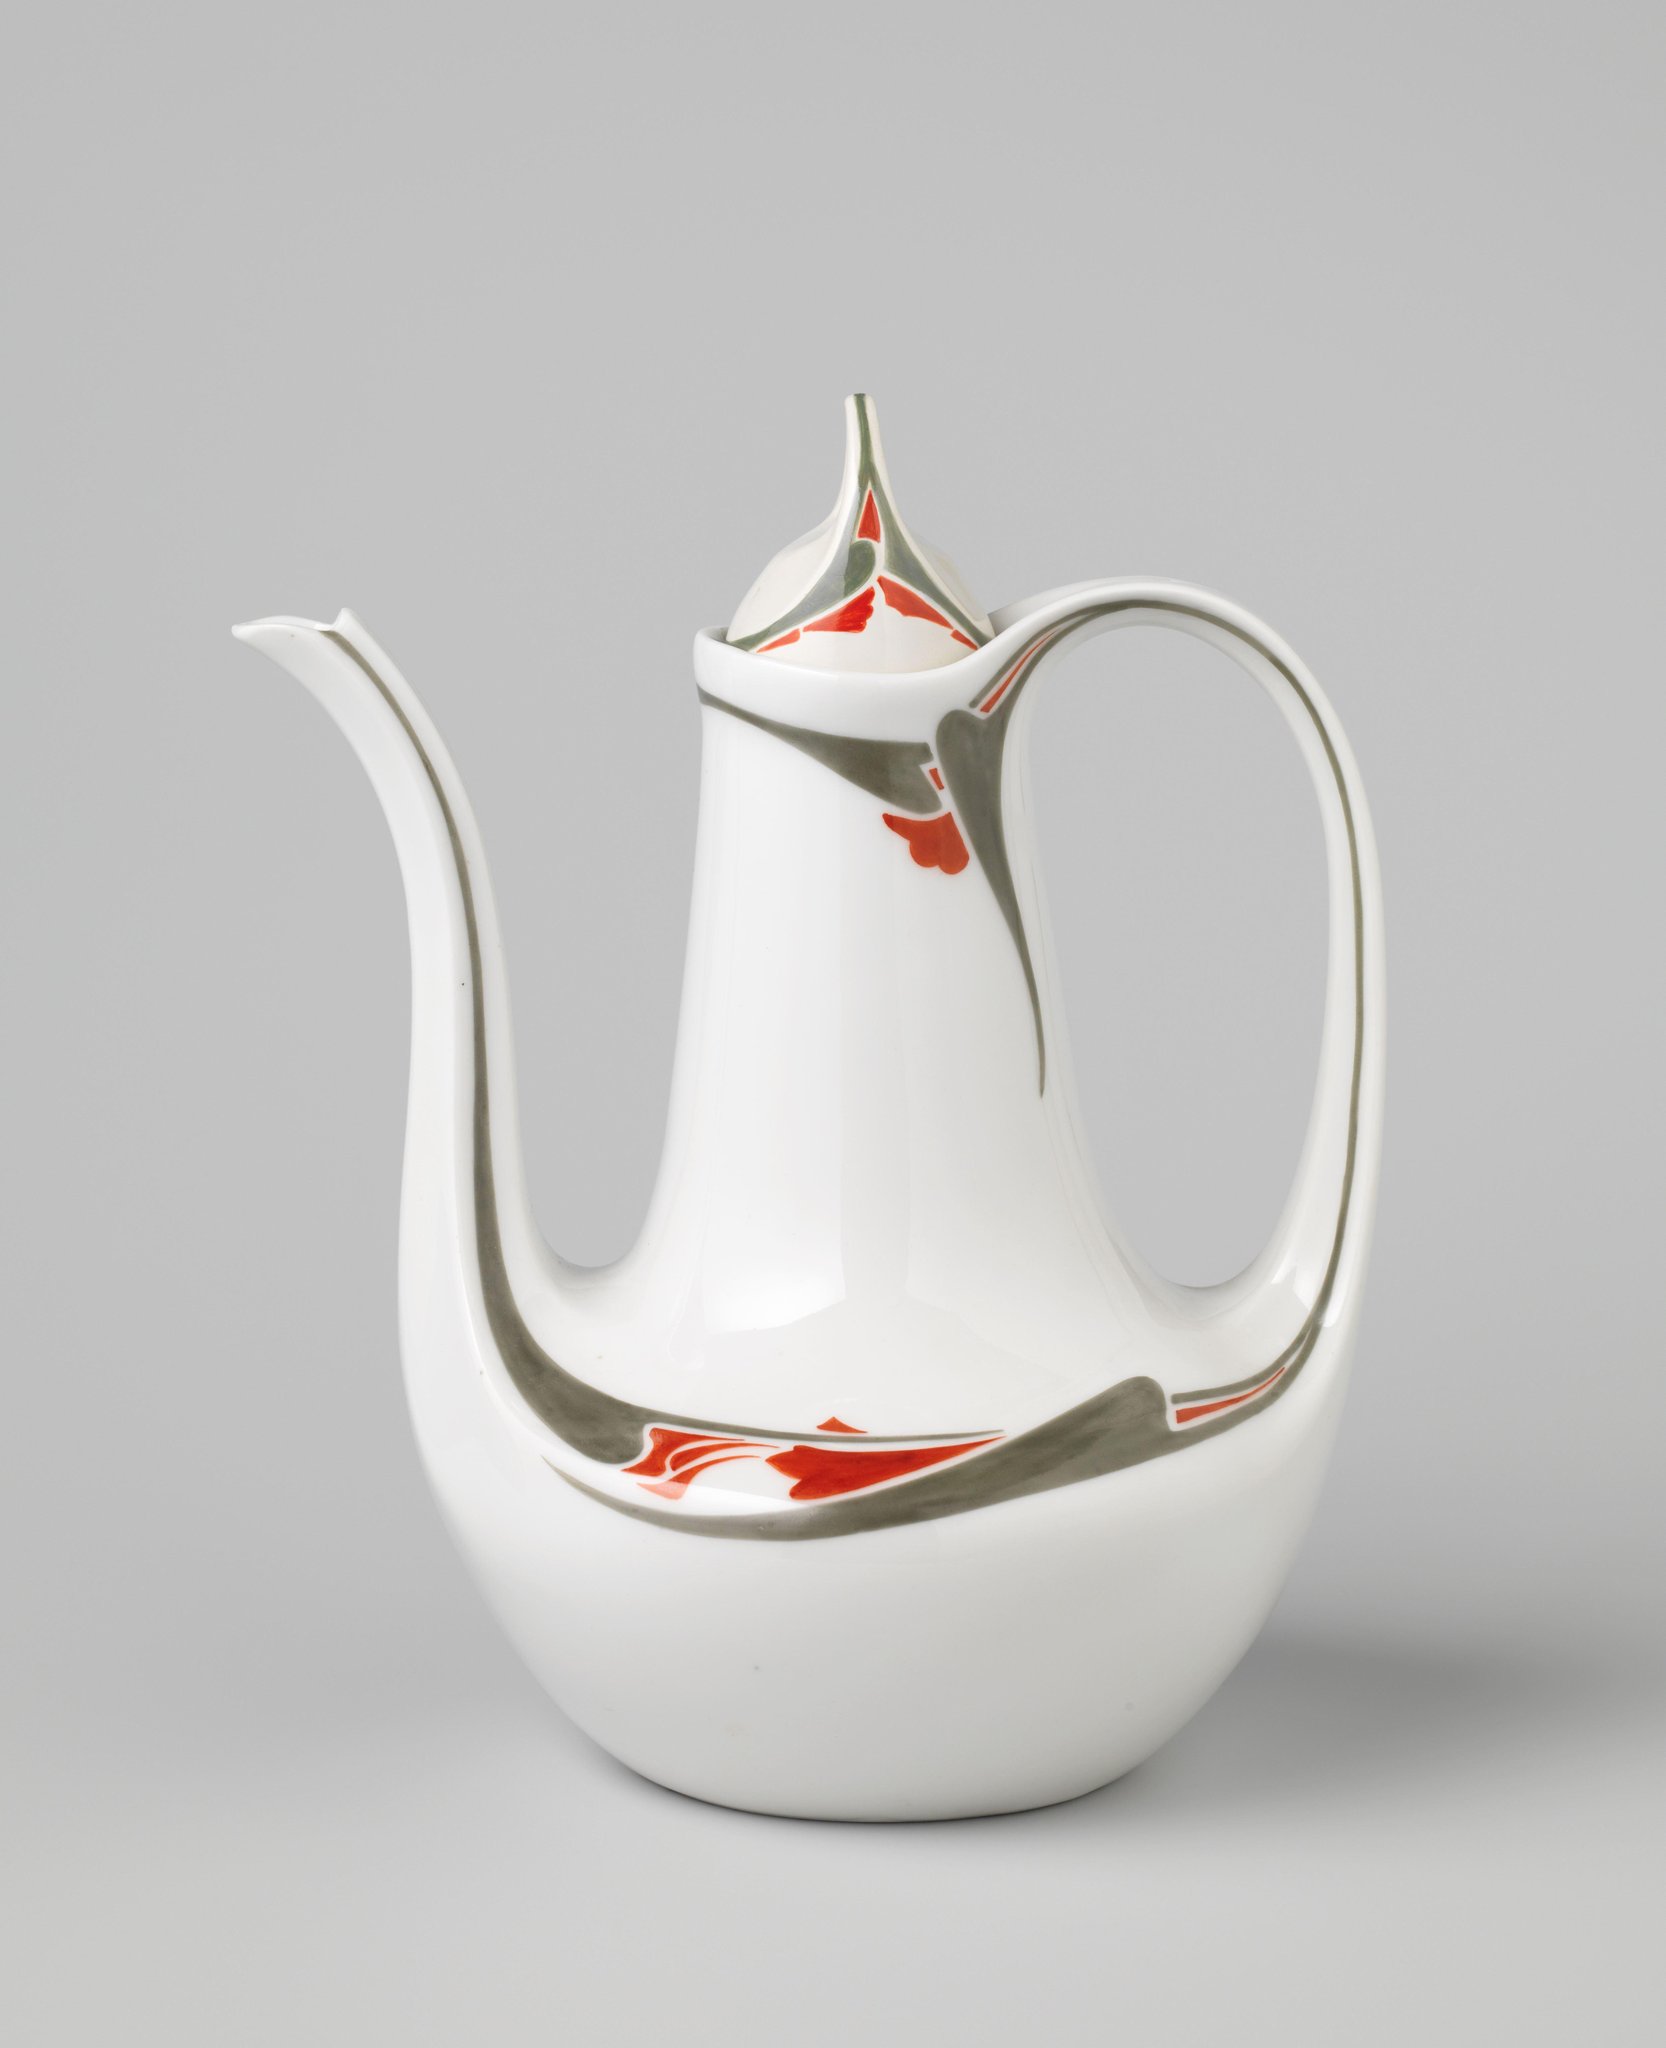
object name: coffee pot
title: Coffeepot with stylized floral motifs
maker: maurice dufrêne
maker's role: designer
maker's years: 1876-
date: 1900-1905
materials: glaze, paint, porcelain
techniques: firing, forming, turning, vitrification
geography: paris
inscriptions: mark: ‘82.R. des Petits Champs/ MML/ La Maison Moderne’, signature: ‘M. DUFRENE’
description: Koffiekan van porselein met een half bolvormig lichaam, platte schouder en lange, vernauwende nek. Licht gebogen tuit en hoog oor vanuit de rand. Beschilderd op het glazuur in groen en rood. Op de buitenwand, doorlopend op de tuit en vanuit het oor naar de nek, gestileerde bloemtakken. De deksel met dezelfde decoratie. Gesigneerd op de basis van het oor met 'M. DUFRENE'. Gemerkt op de onderzijde met '82.R. des Petits Champs/ MML/ La Maison Moderne'. Naar ontwerp van Maurice Dufrêne, vervaardigd voor La Maison Moderne, mogelijk door Le Parthénon, Parijs. De deksel is een kunststof vervanging voor het origineel.